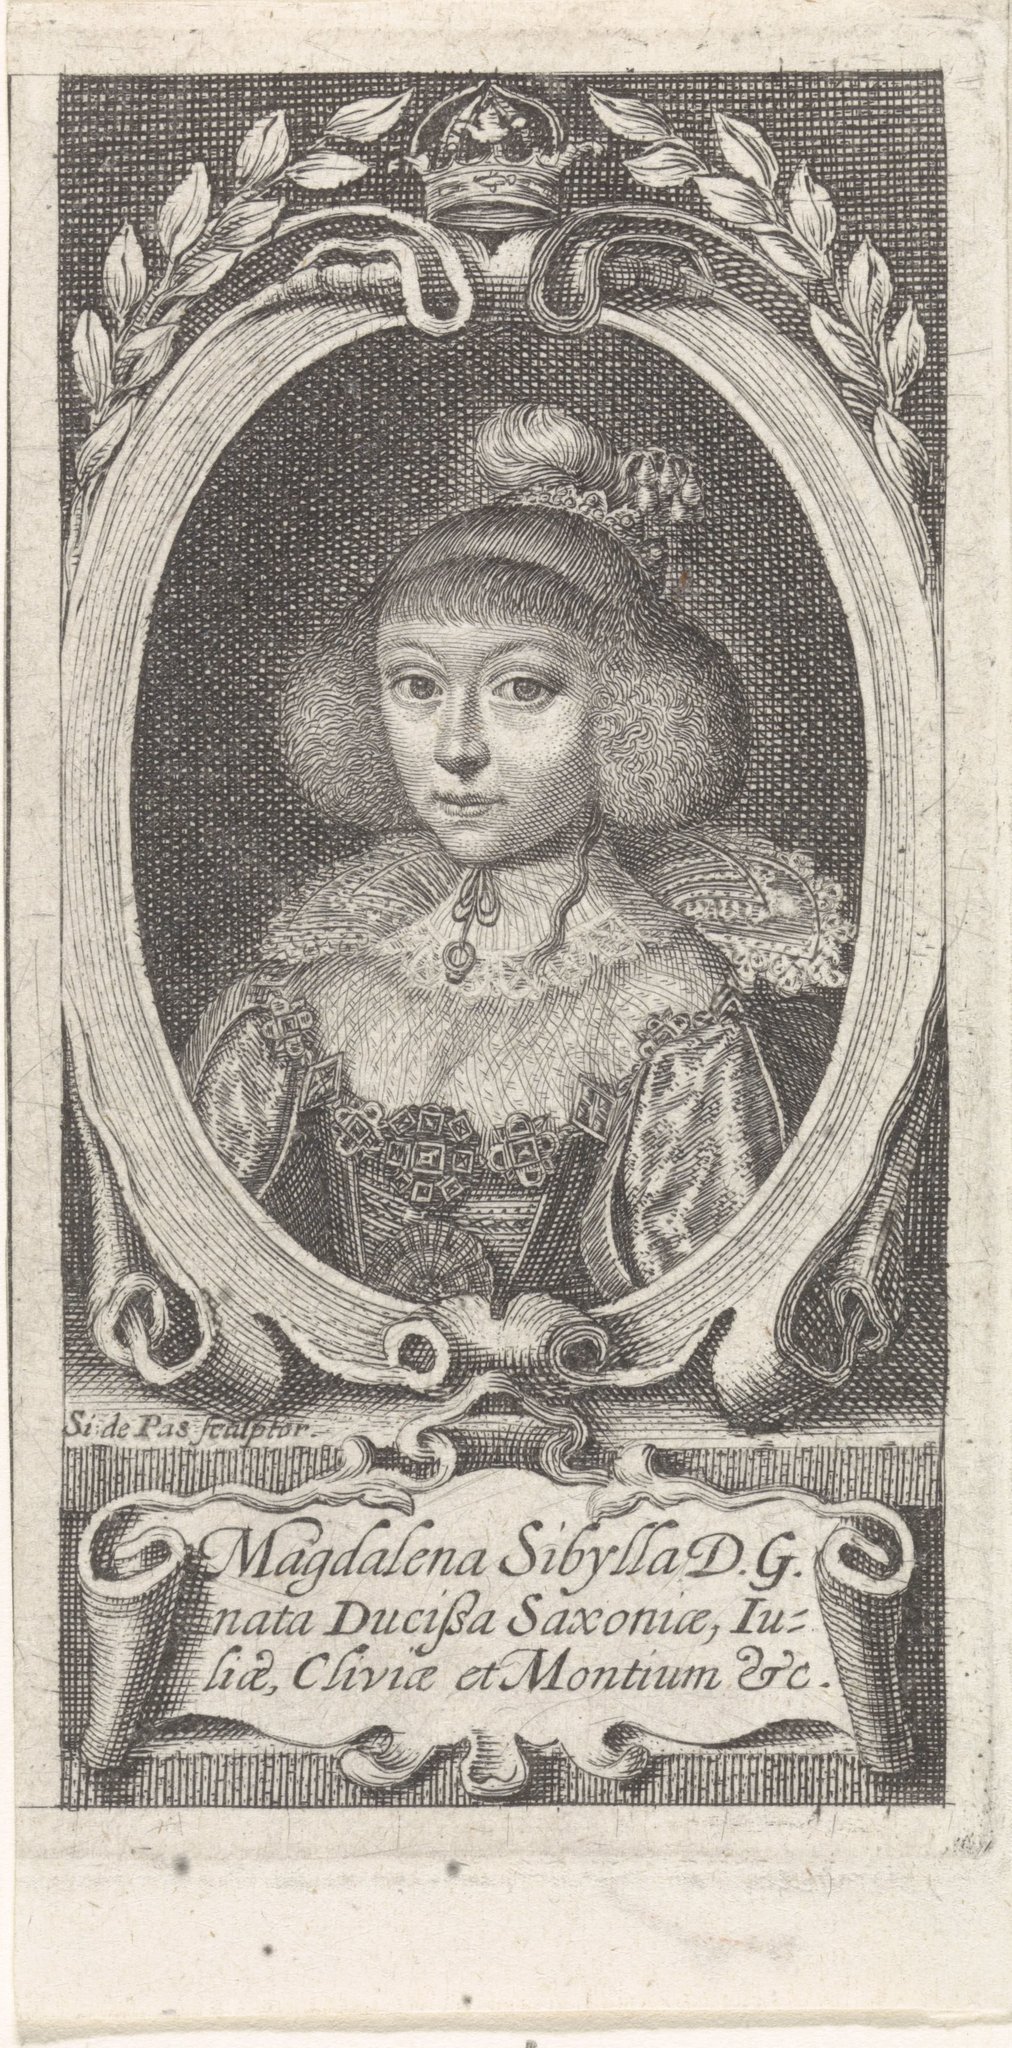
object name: print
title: Portret van Magdalena Sibylla van Saksen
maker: simon van de passe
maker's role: print maker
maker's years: 1595-1647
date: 1624-1647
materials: paper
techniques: engraving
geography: copenhagen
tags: magdalena sibylla van saksen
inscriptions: collector's mark: Lugt 240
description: Portret van Magdalena Sibylla van Saksen, gemalin van de Deense erfprins Christiaan van Denemarken.